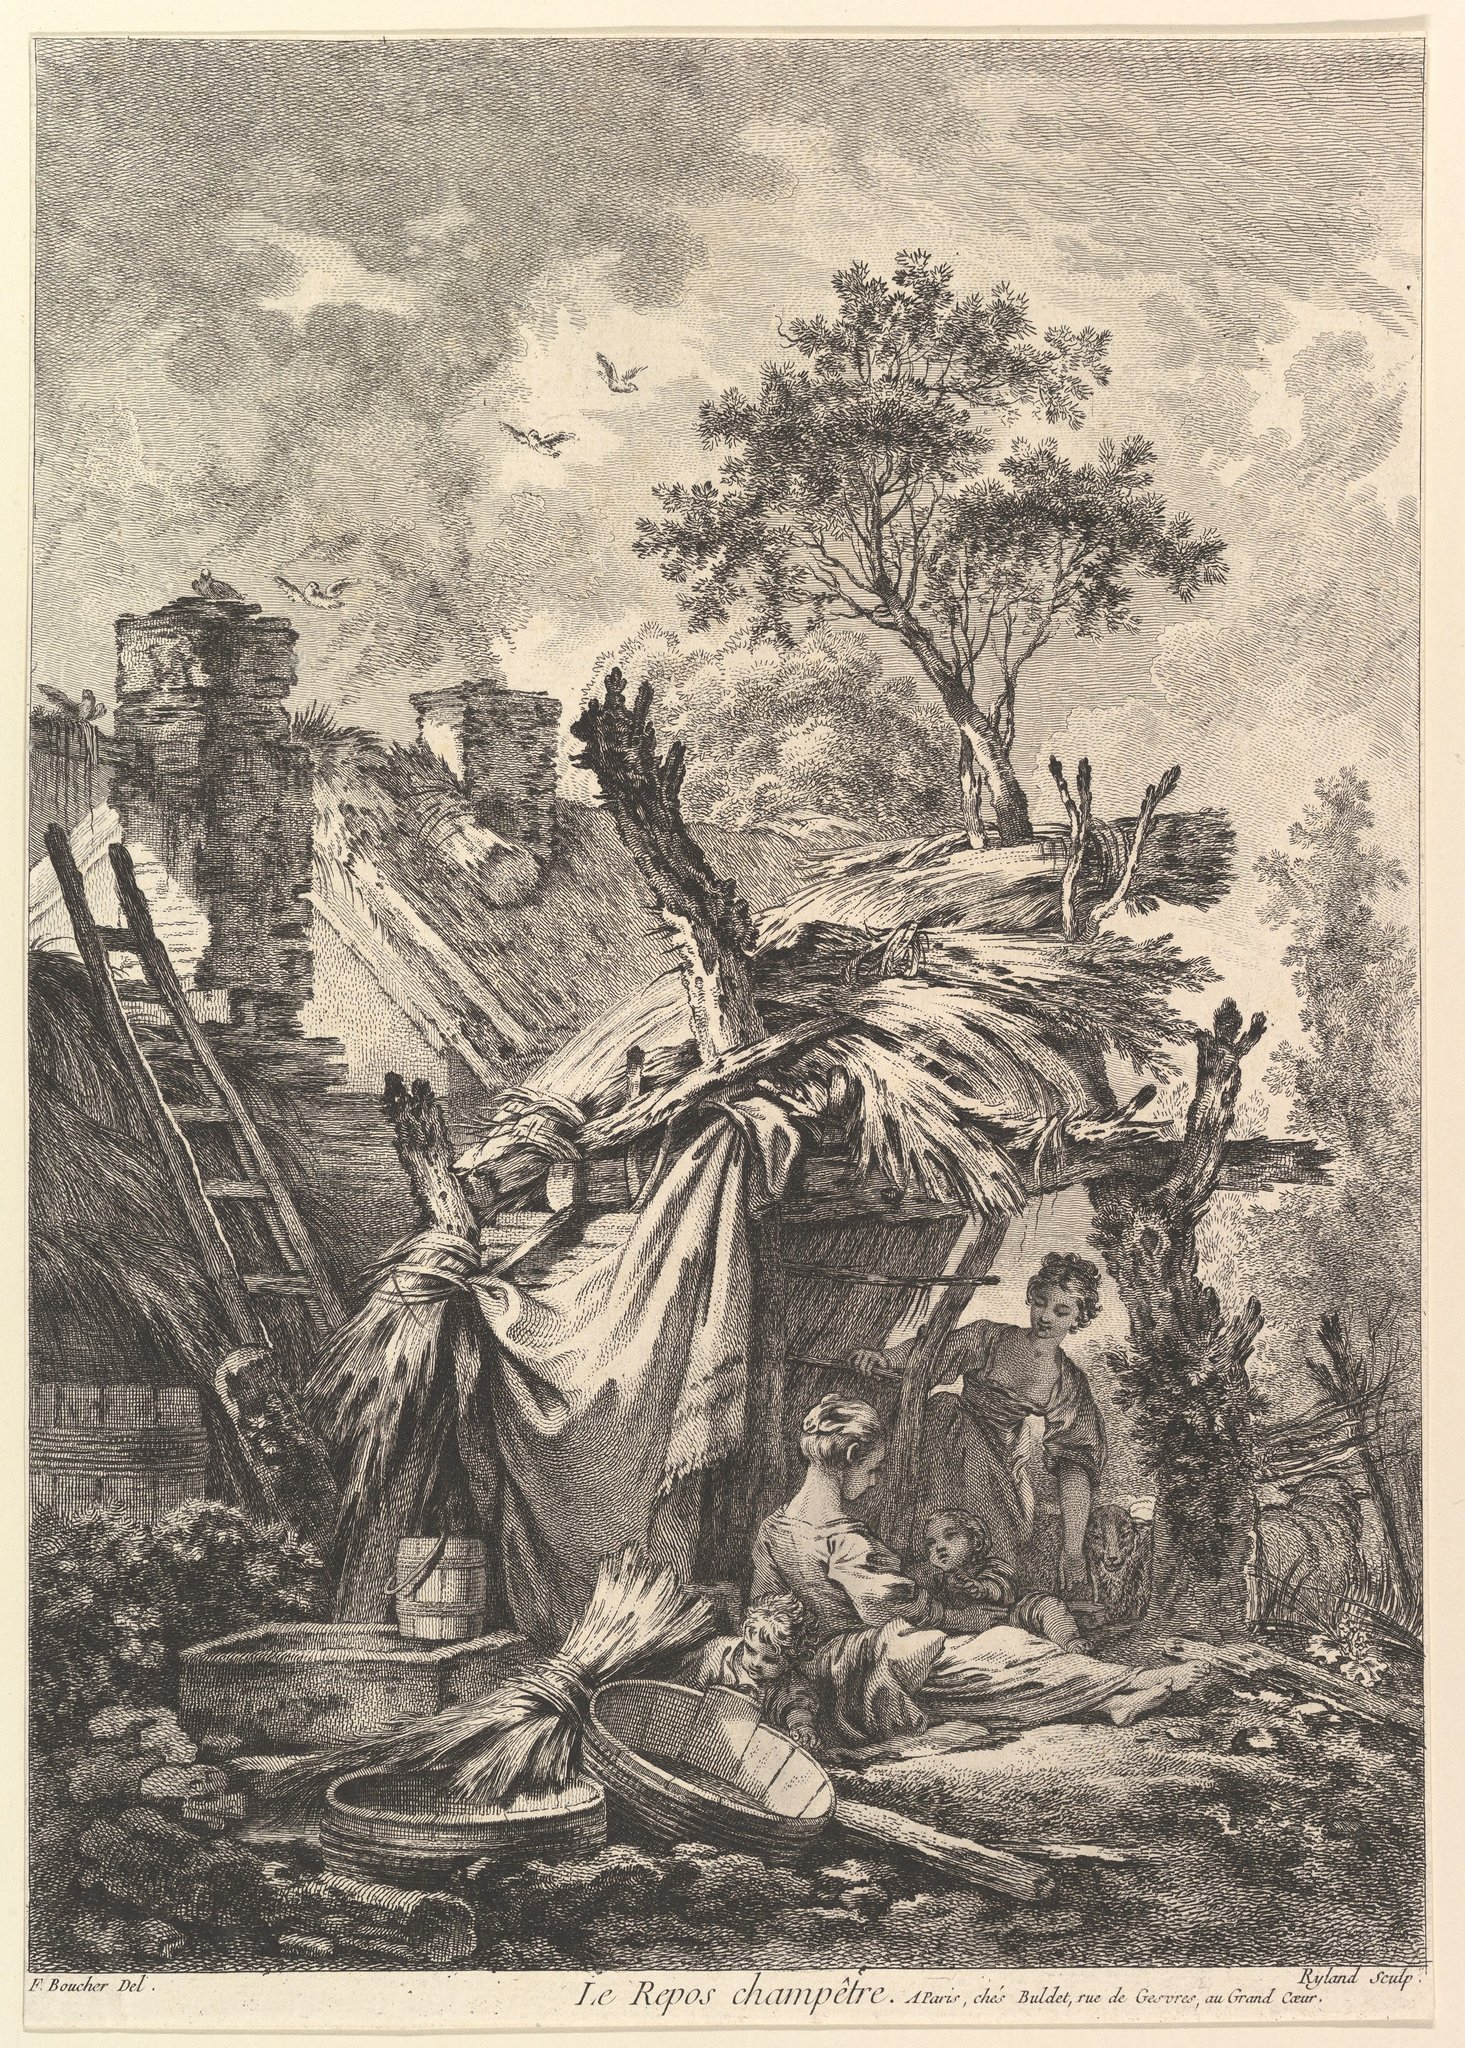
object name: print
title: Rest in the Country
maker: william wynne ryland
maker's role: artist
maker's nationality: british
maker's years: 1732-1783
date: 1732-1783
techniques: engraving, etching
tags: infants,women